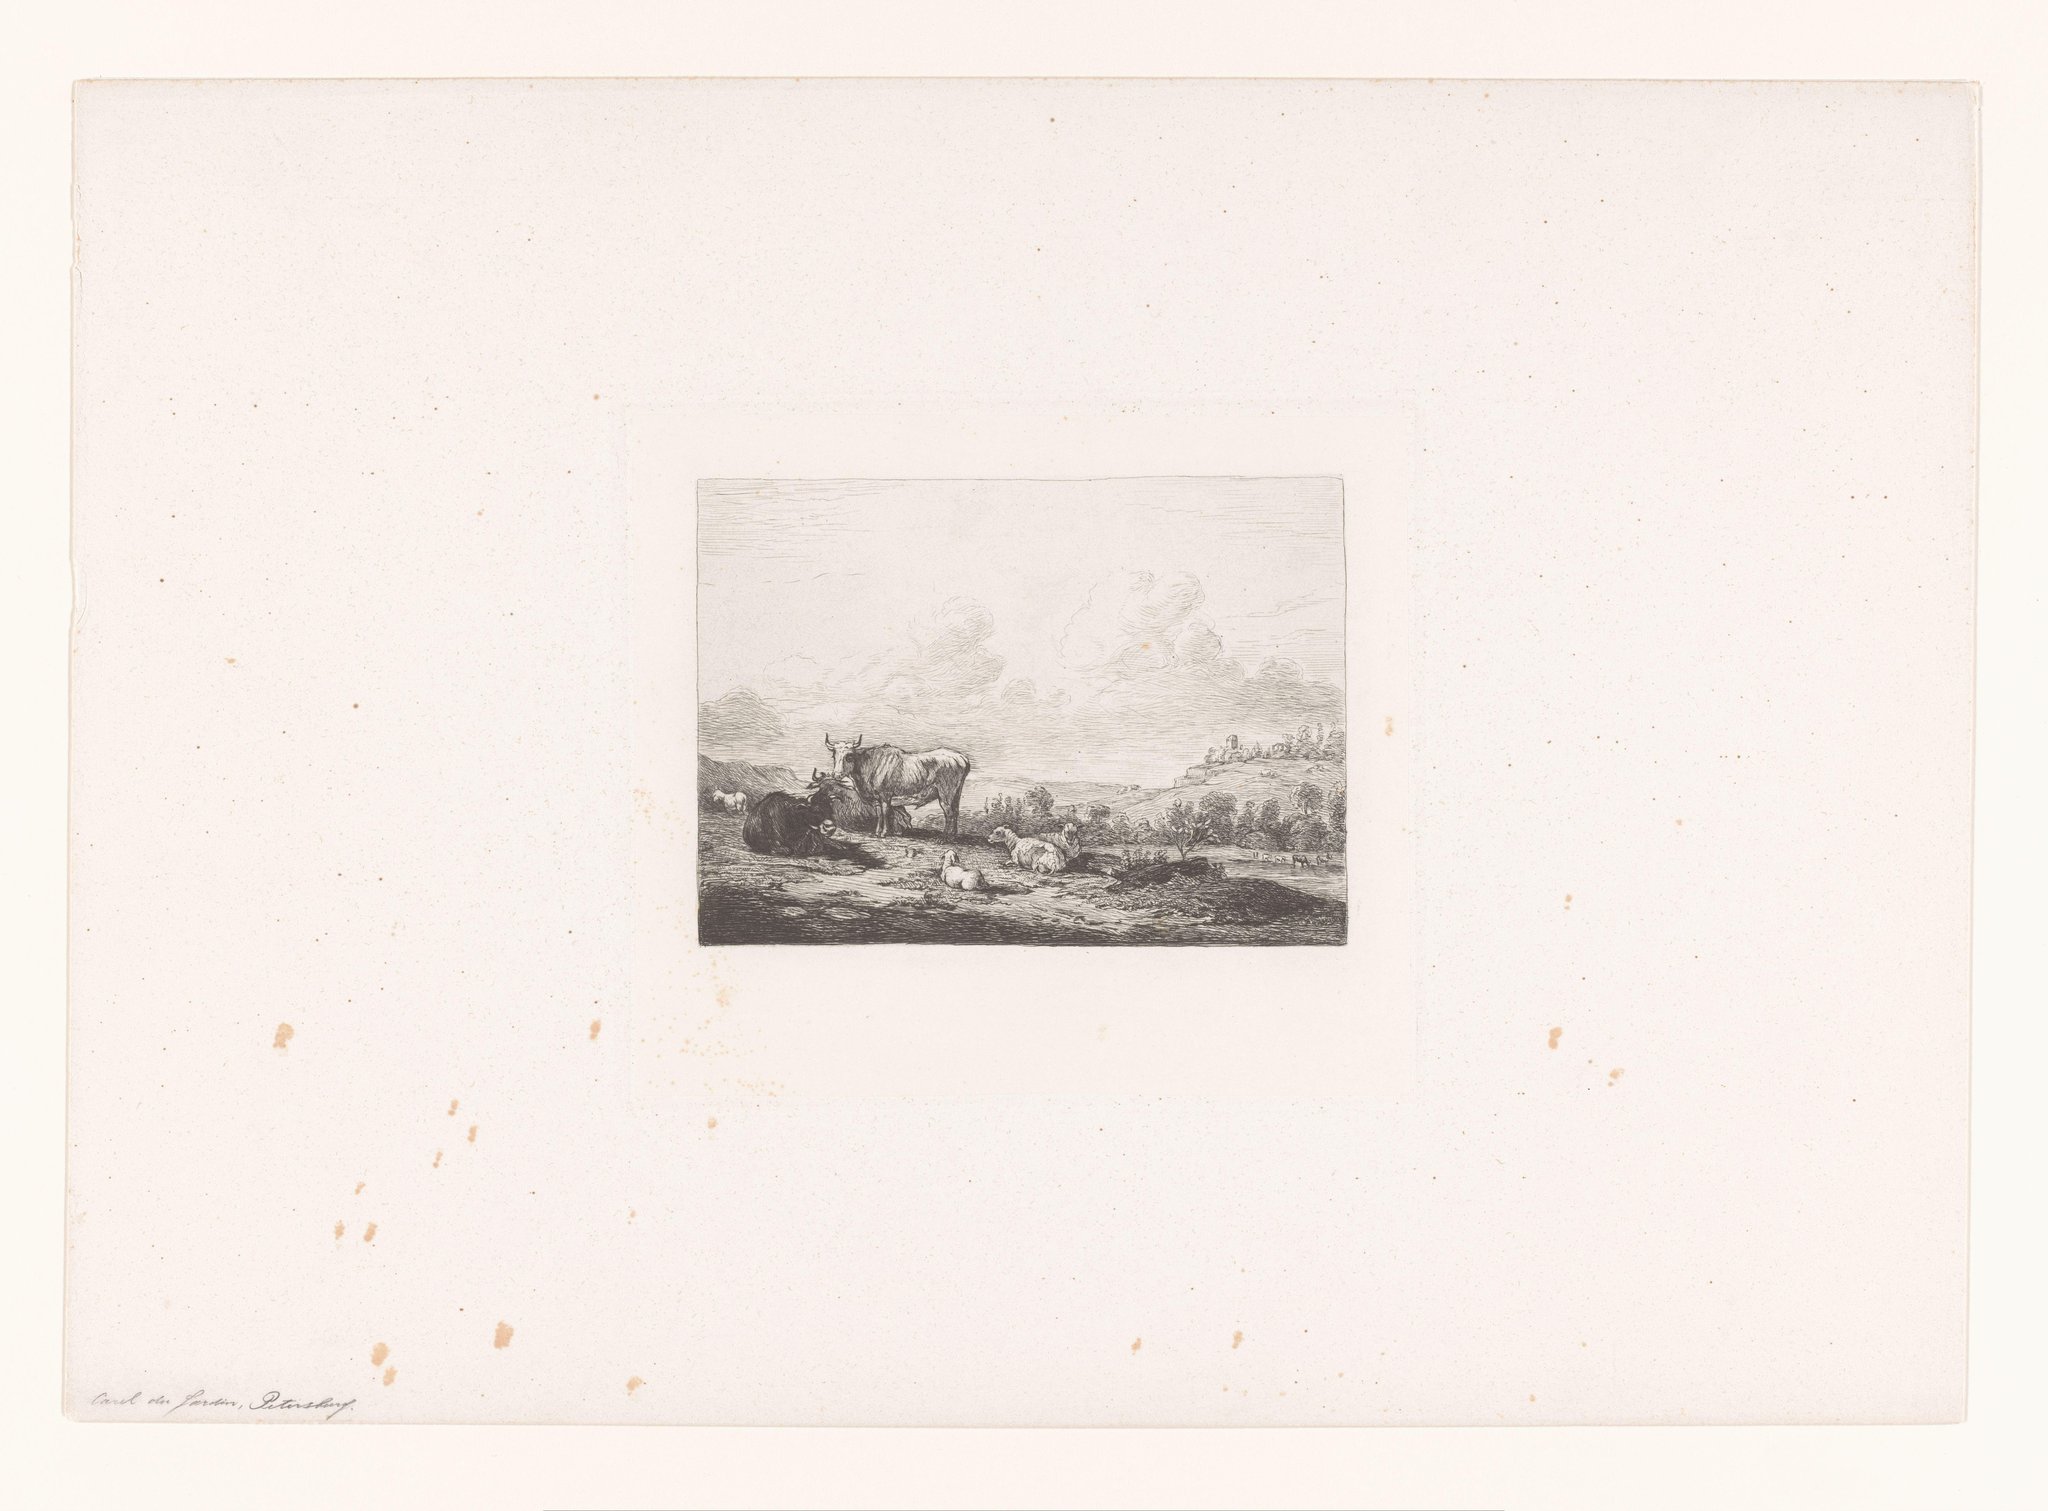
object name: print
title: Landschap met schapen en runderen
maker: nikolay semyonovich mosolov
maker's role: print maker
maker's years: 1847-1914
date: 1857-1914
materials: paper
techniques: drypoint, etching, intaglio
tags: landscapes in the temperate zone, sheep, bovine cattle